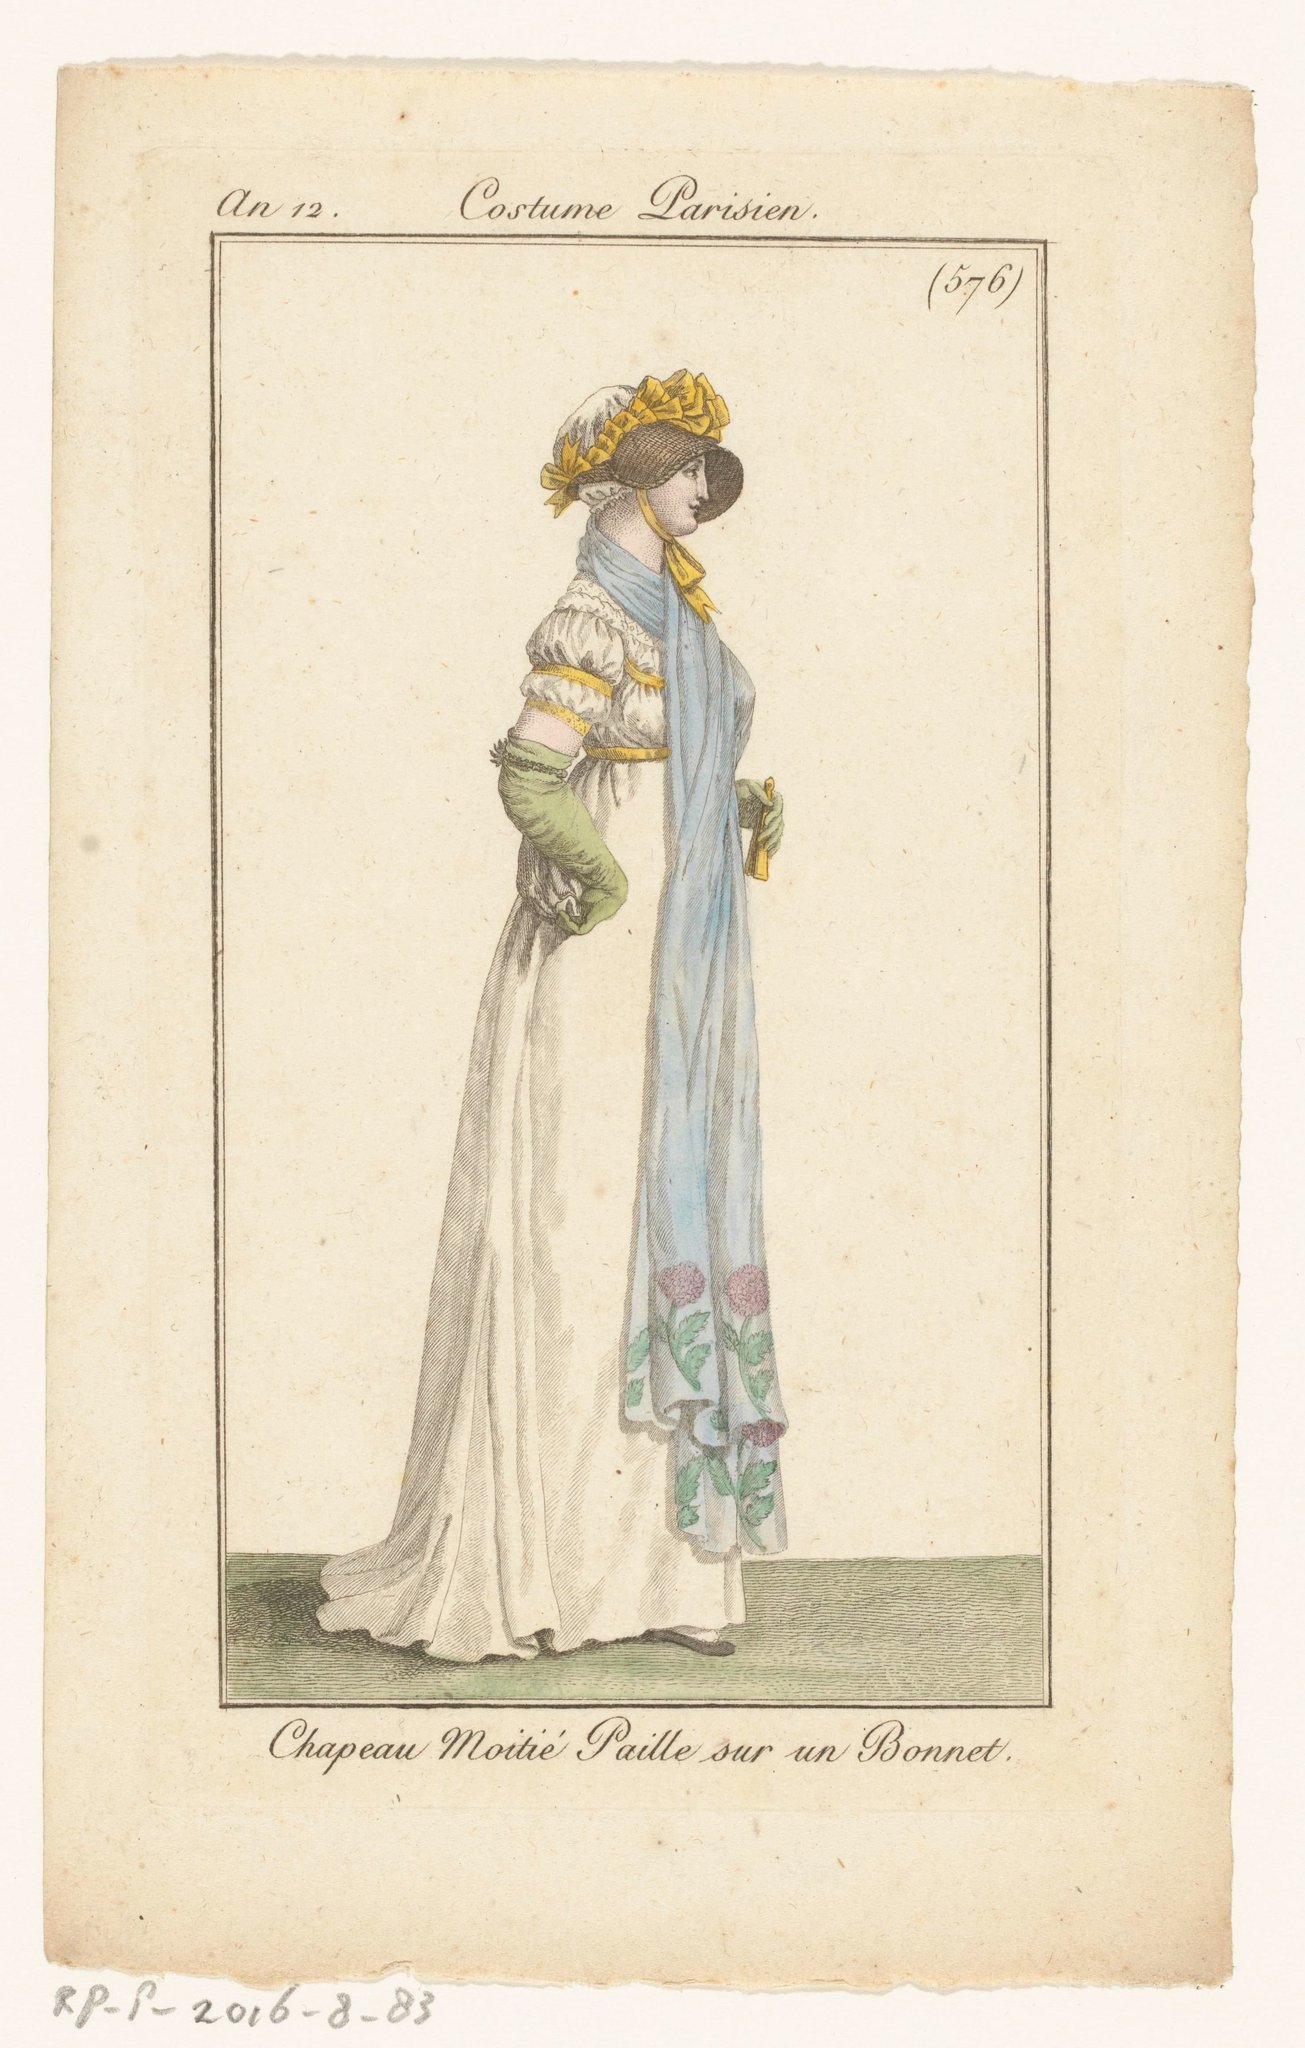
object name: fashion print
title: Journal des Dames et des modes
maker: Anonymous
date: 1803-1804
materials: paper, ink, watercolor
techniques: etching, hand coloring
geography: france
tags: fashion plates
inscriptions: collector's mark: Lugt 2228